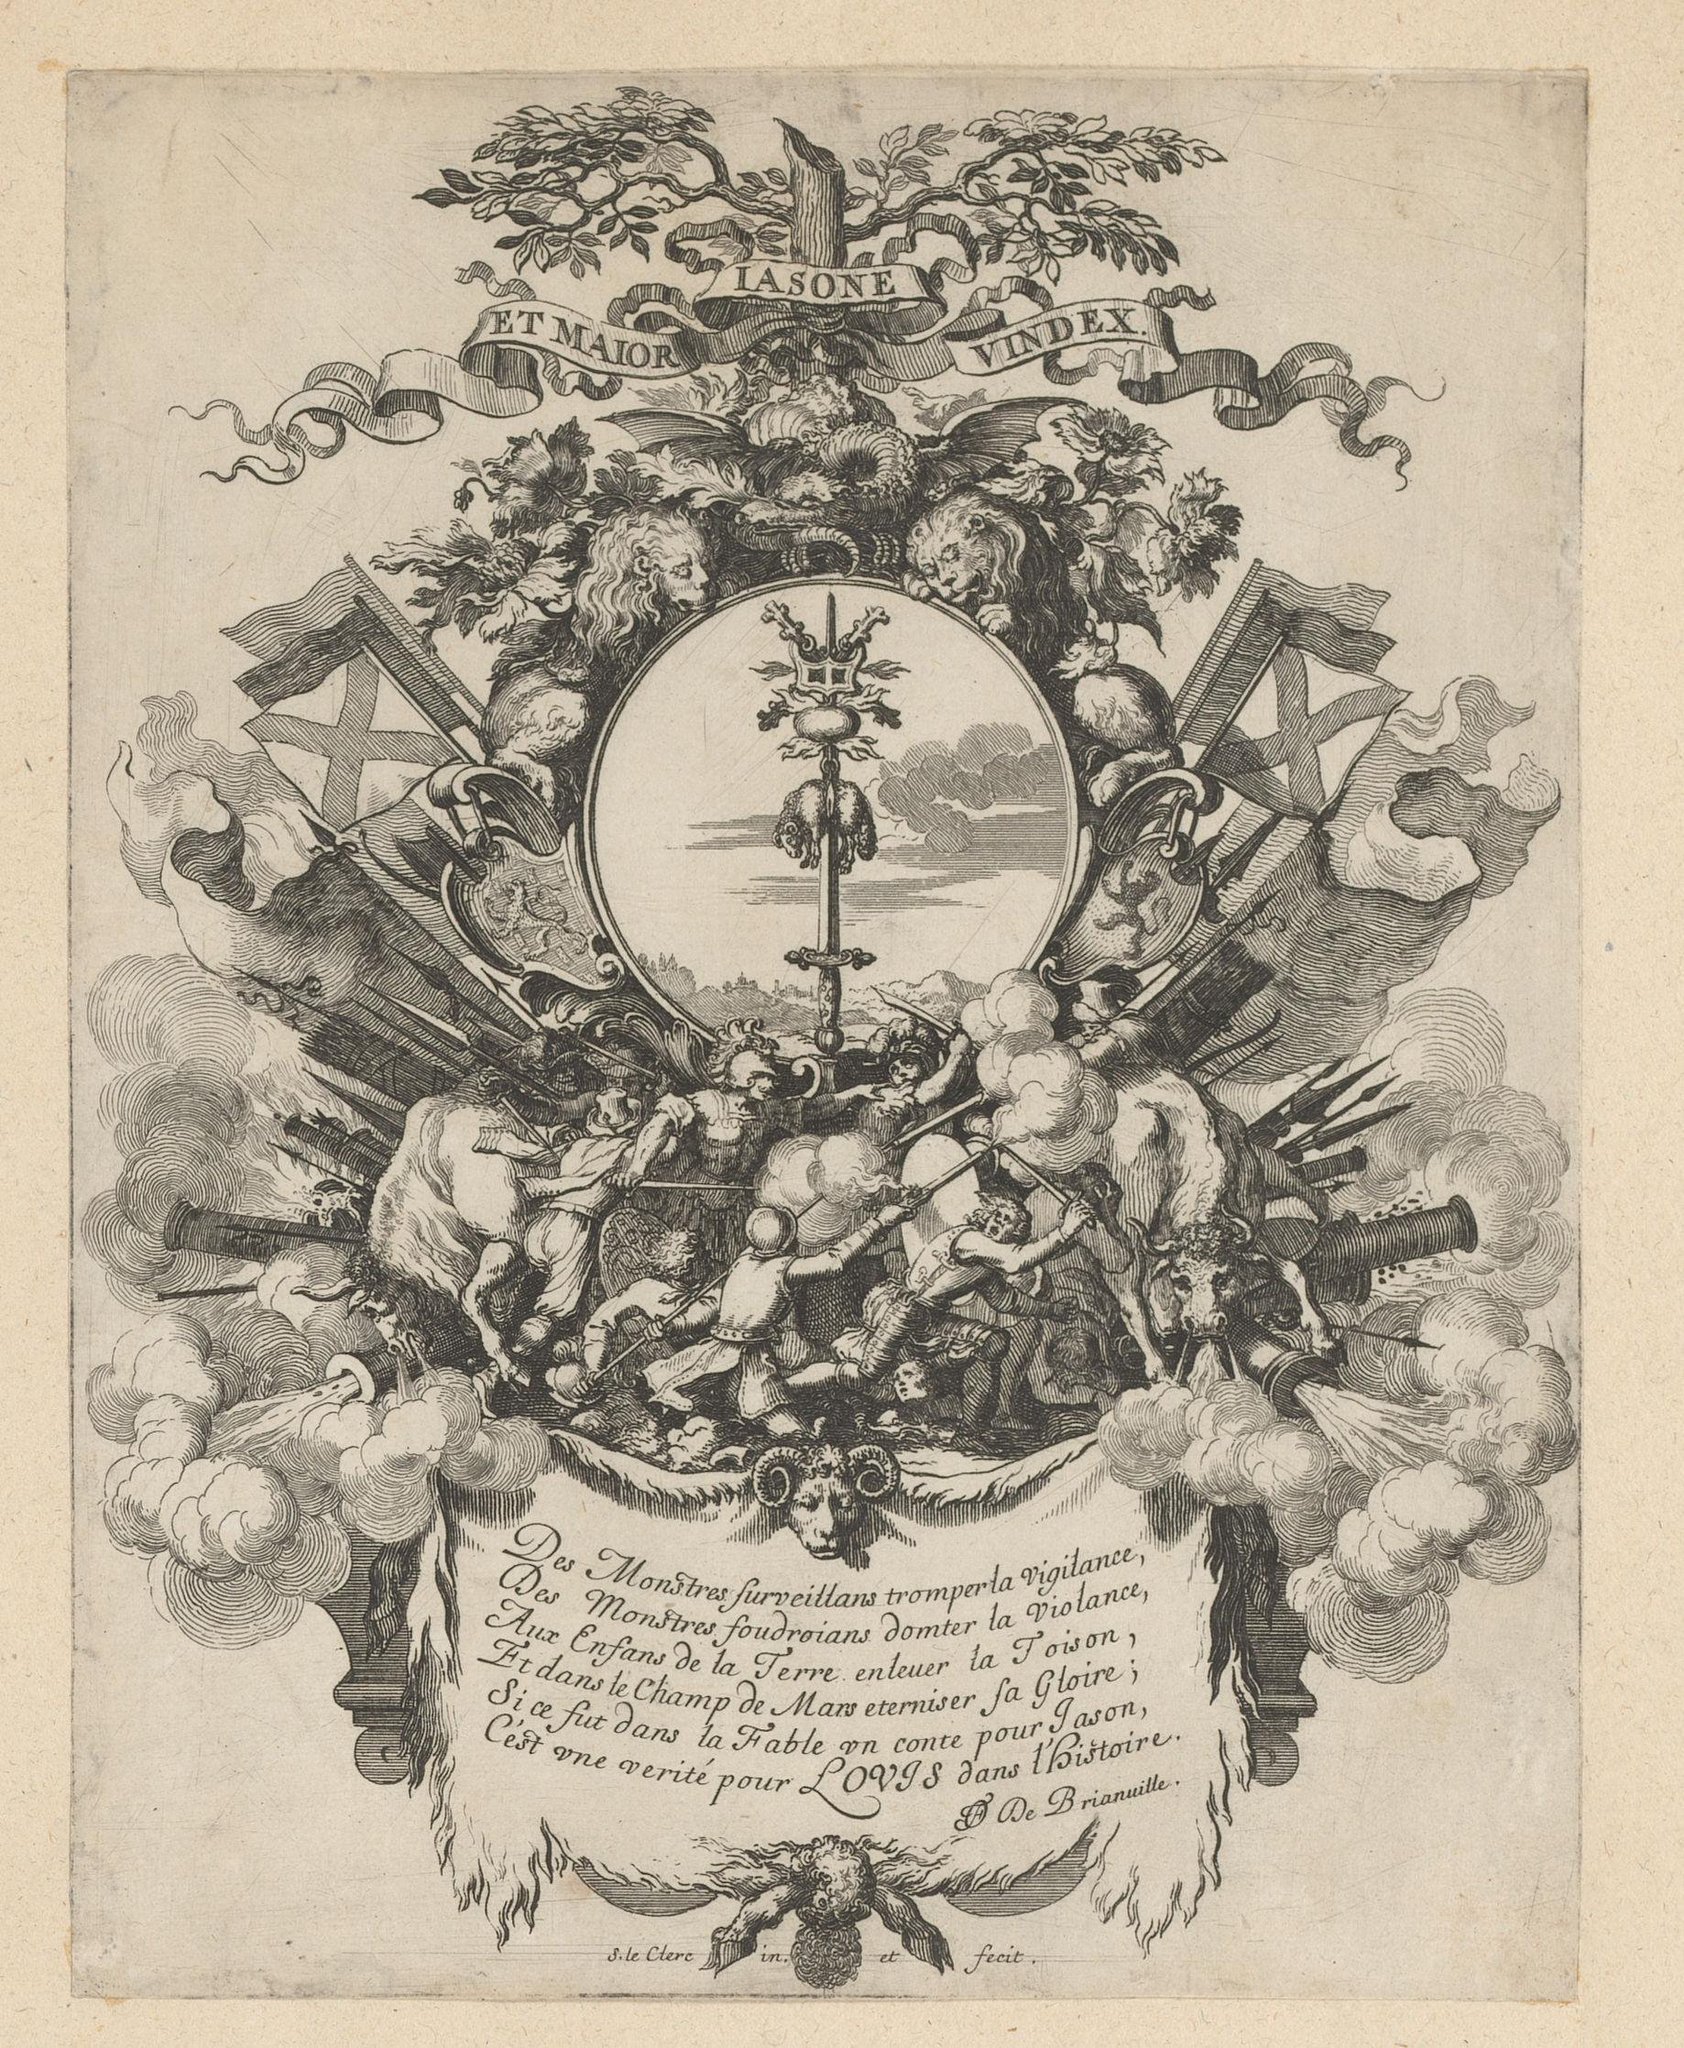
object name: book illustration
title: Trofee met het Gulden Vlies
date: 1668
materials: paper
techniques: etching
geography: paris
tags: battle, knighthood order of the golden fleece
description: Prent gebruikt voor: Brianville, Oronce Finé de. Symbole heroique pour les dernieres conquestes du Roy. Parijs: Charles de Sercy, 1668.